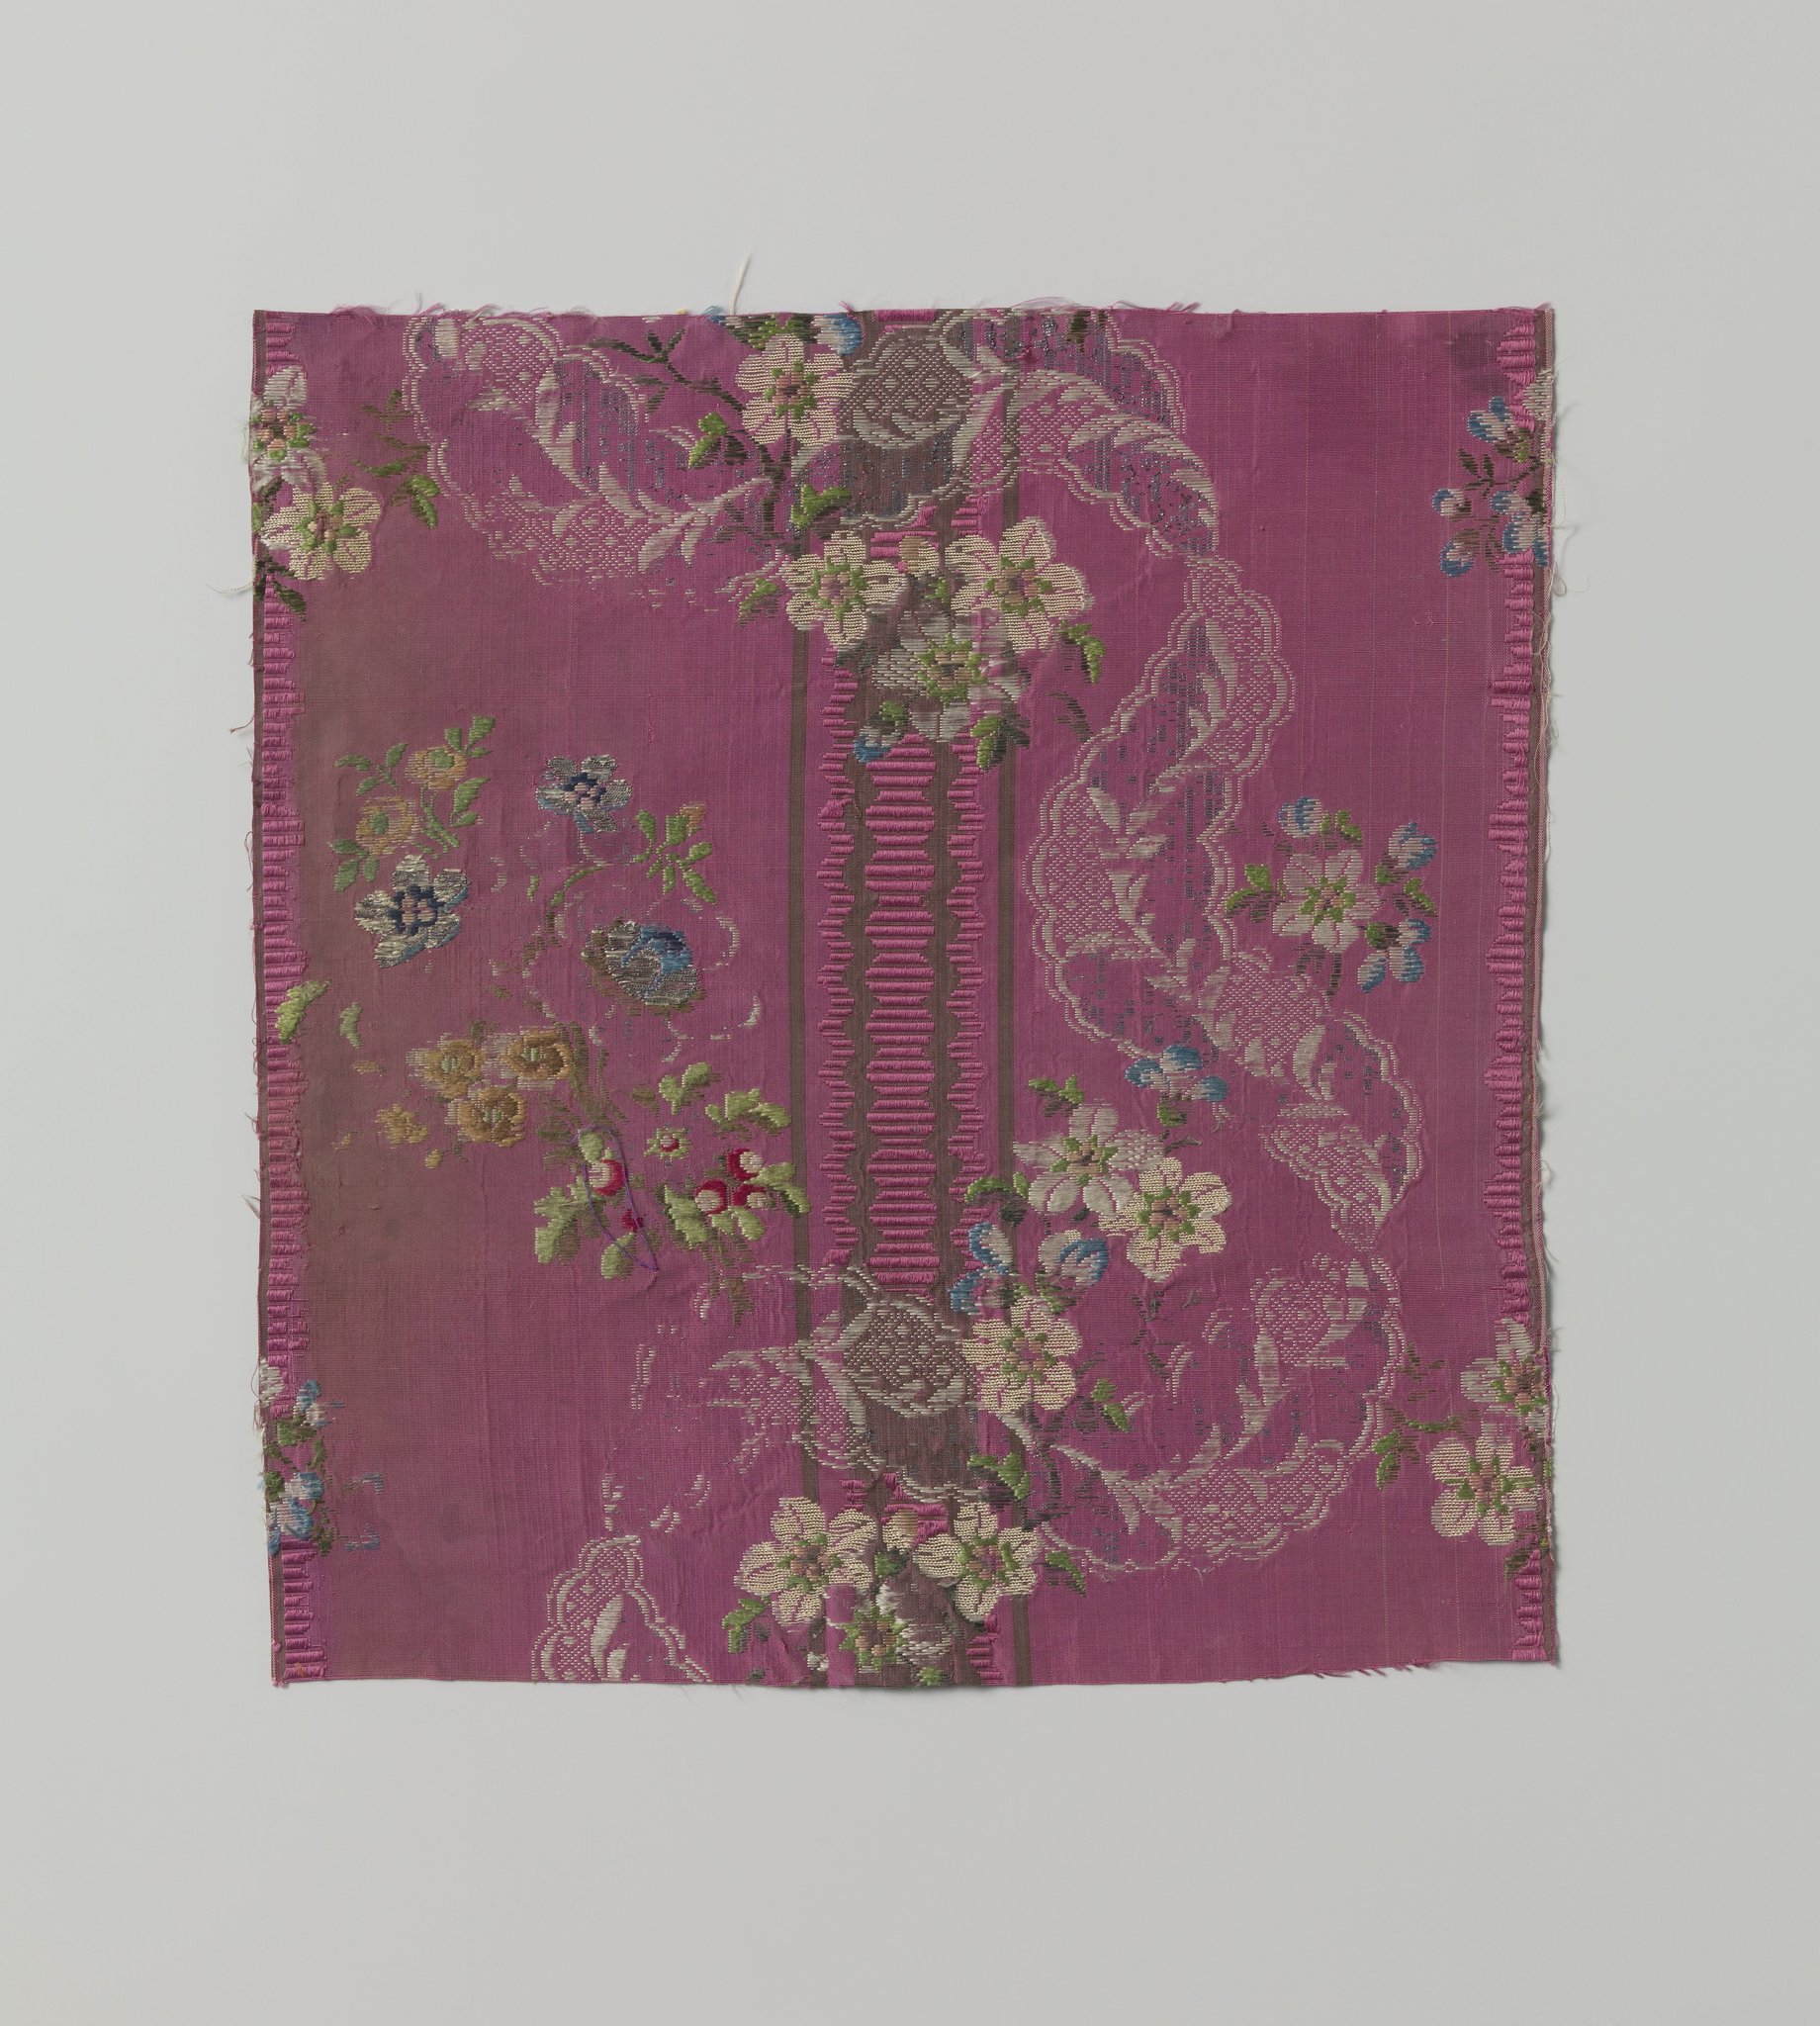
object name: fragment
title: Fragment veelkleurig zijde mexicaine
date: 1765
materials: silk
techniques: brocade, gadrooning, weave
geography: france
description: Twee fragmenten veelkleurig zijdeweefsel. Een paarse grond heeft paarse strepen waarop een witte kantslinger en gestrooide veelkleurige bloemboeketten.